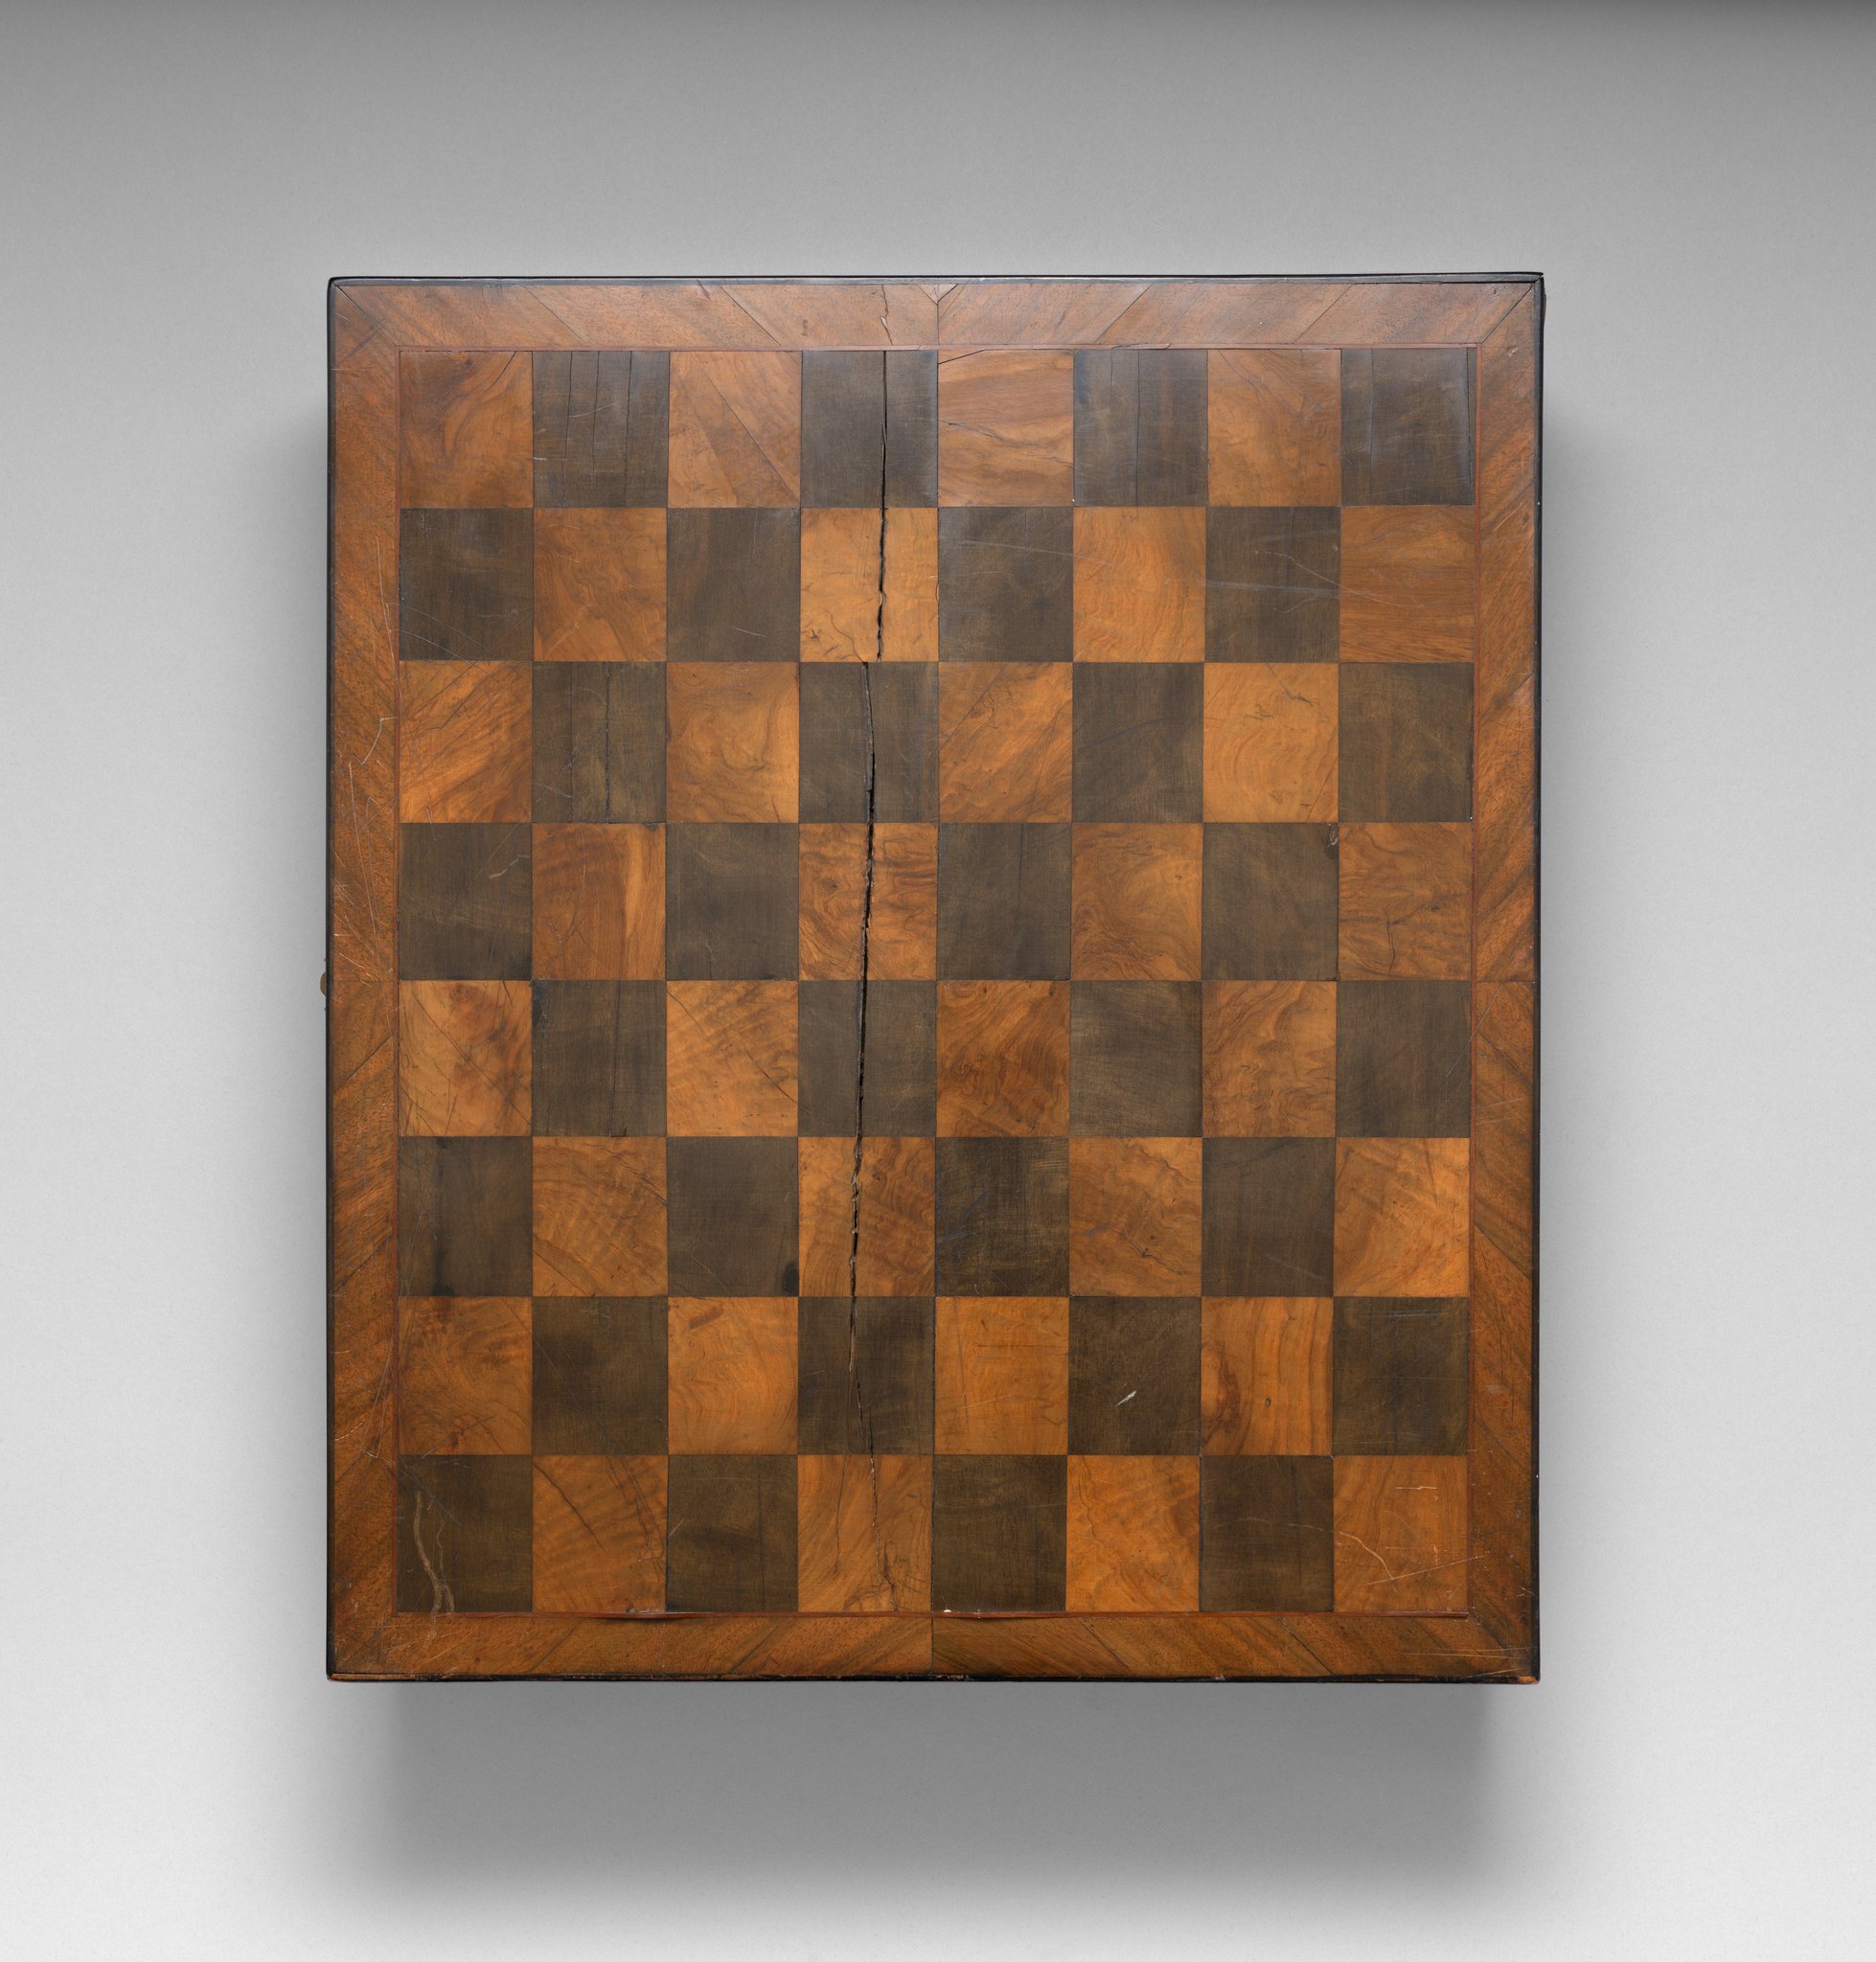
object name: chess and backgammon board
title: Box-board for chess and backgammon or tric-trac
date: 1801-1900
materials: brass, wood